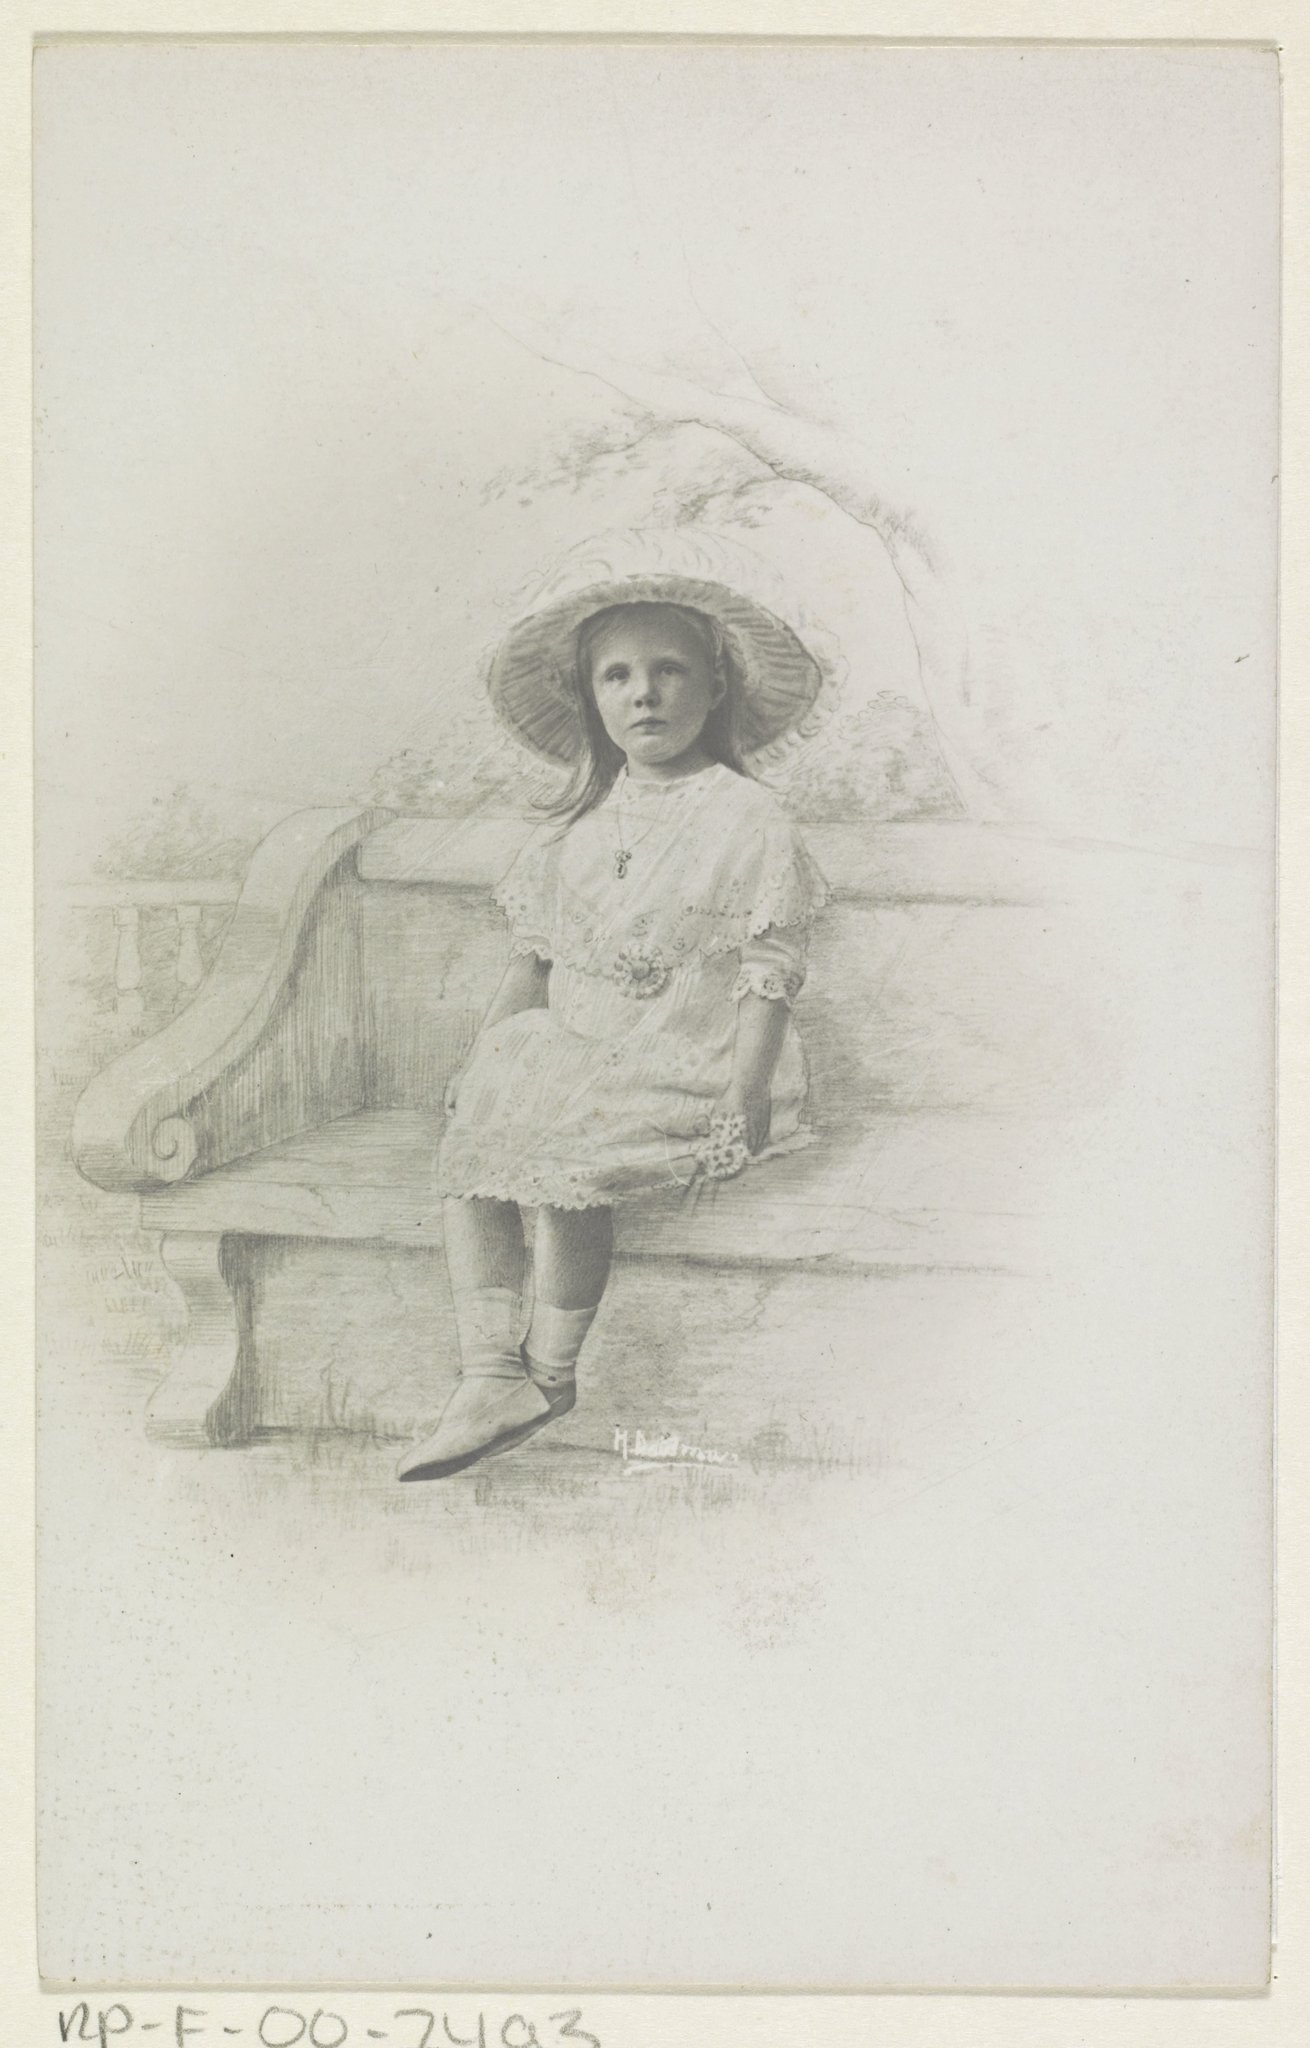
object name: ansichtkaart, prentbriefkaart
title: Portret van Juliana, koningin der Nederlanden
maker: herman deutmann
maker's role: fotograaf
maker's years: 1870-1926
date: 1912-1916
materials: photographic support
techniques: photography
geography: the hague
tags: juliana of the netherlands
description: De hier vermelde titel verwijst naar de hoogst verkregen titel van de geportretteerde, niet per se naar de titel die de geportretteerde op deze voorstelling draagt. Het is waarschijnlijk een bewerkte foto.